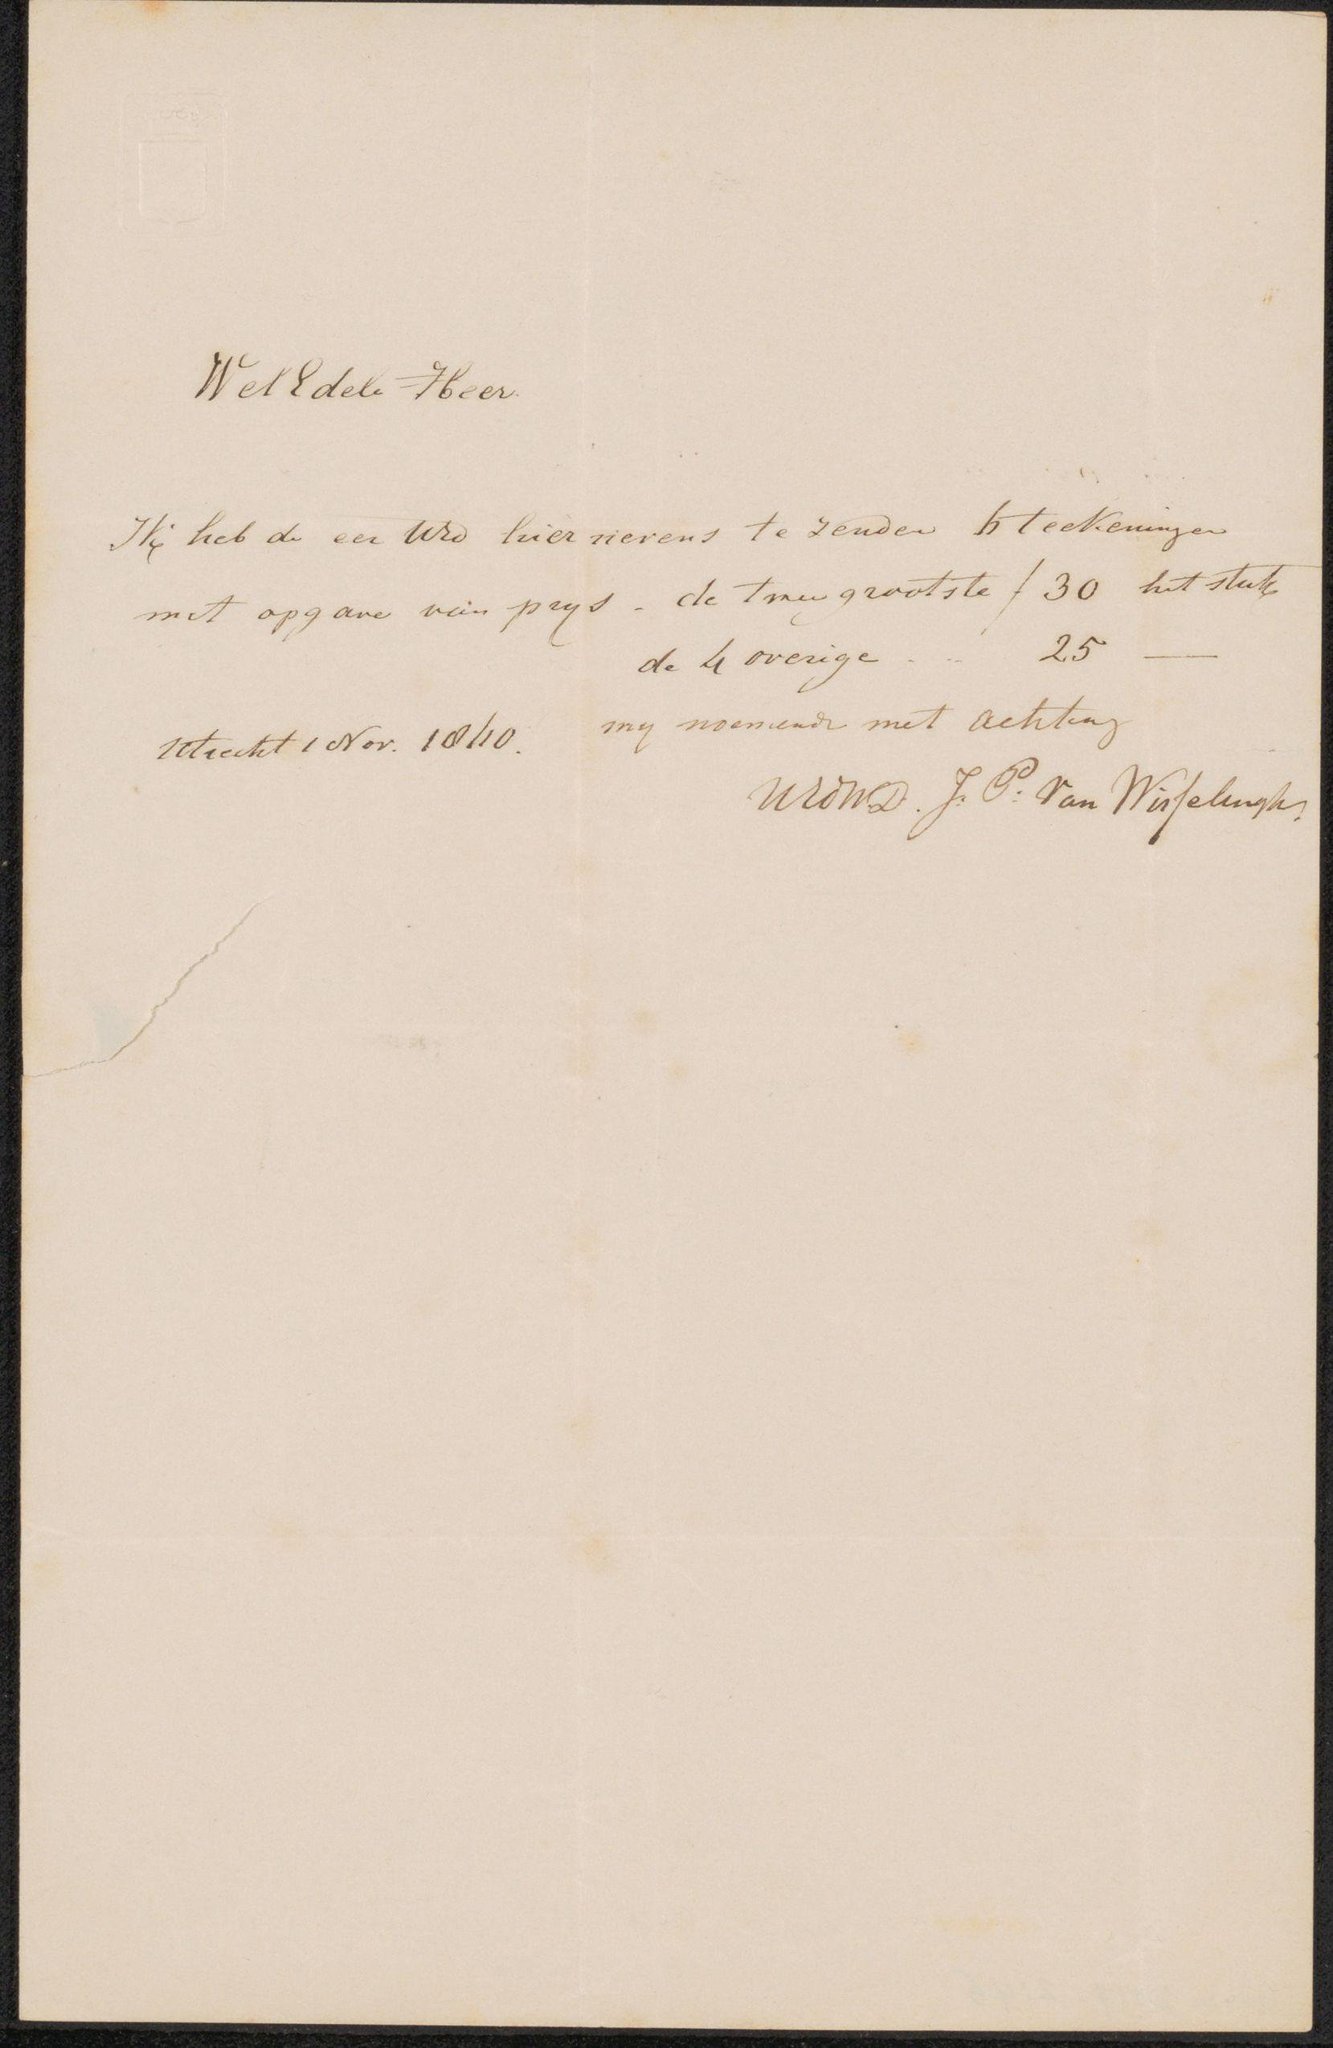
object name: letter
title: Brief aan Pieter Verloren van Themaat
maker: johannes pieter van wisselingh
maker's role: draughtsman, painter, print maker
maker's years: 1812-1899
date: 1860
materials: ink, paper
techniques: pen, writing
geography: utrecht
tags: utrecht, pieter verloren van themaat, drawing, money